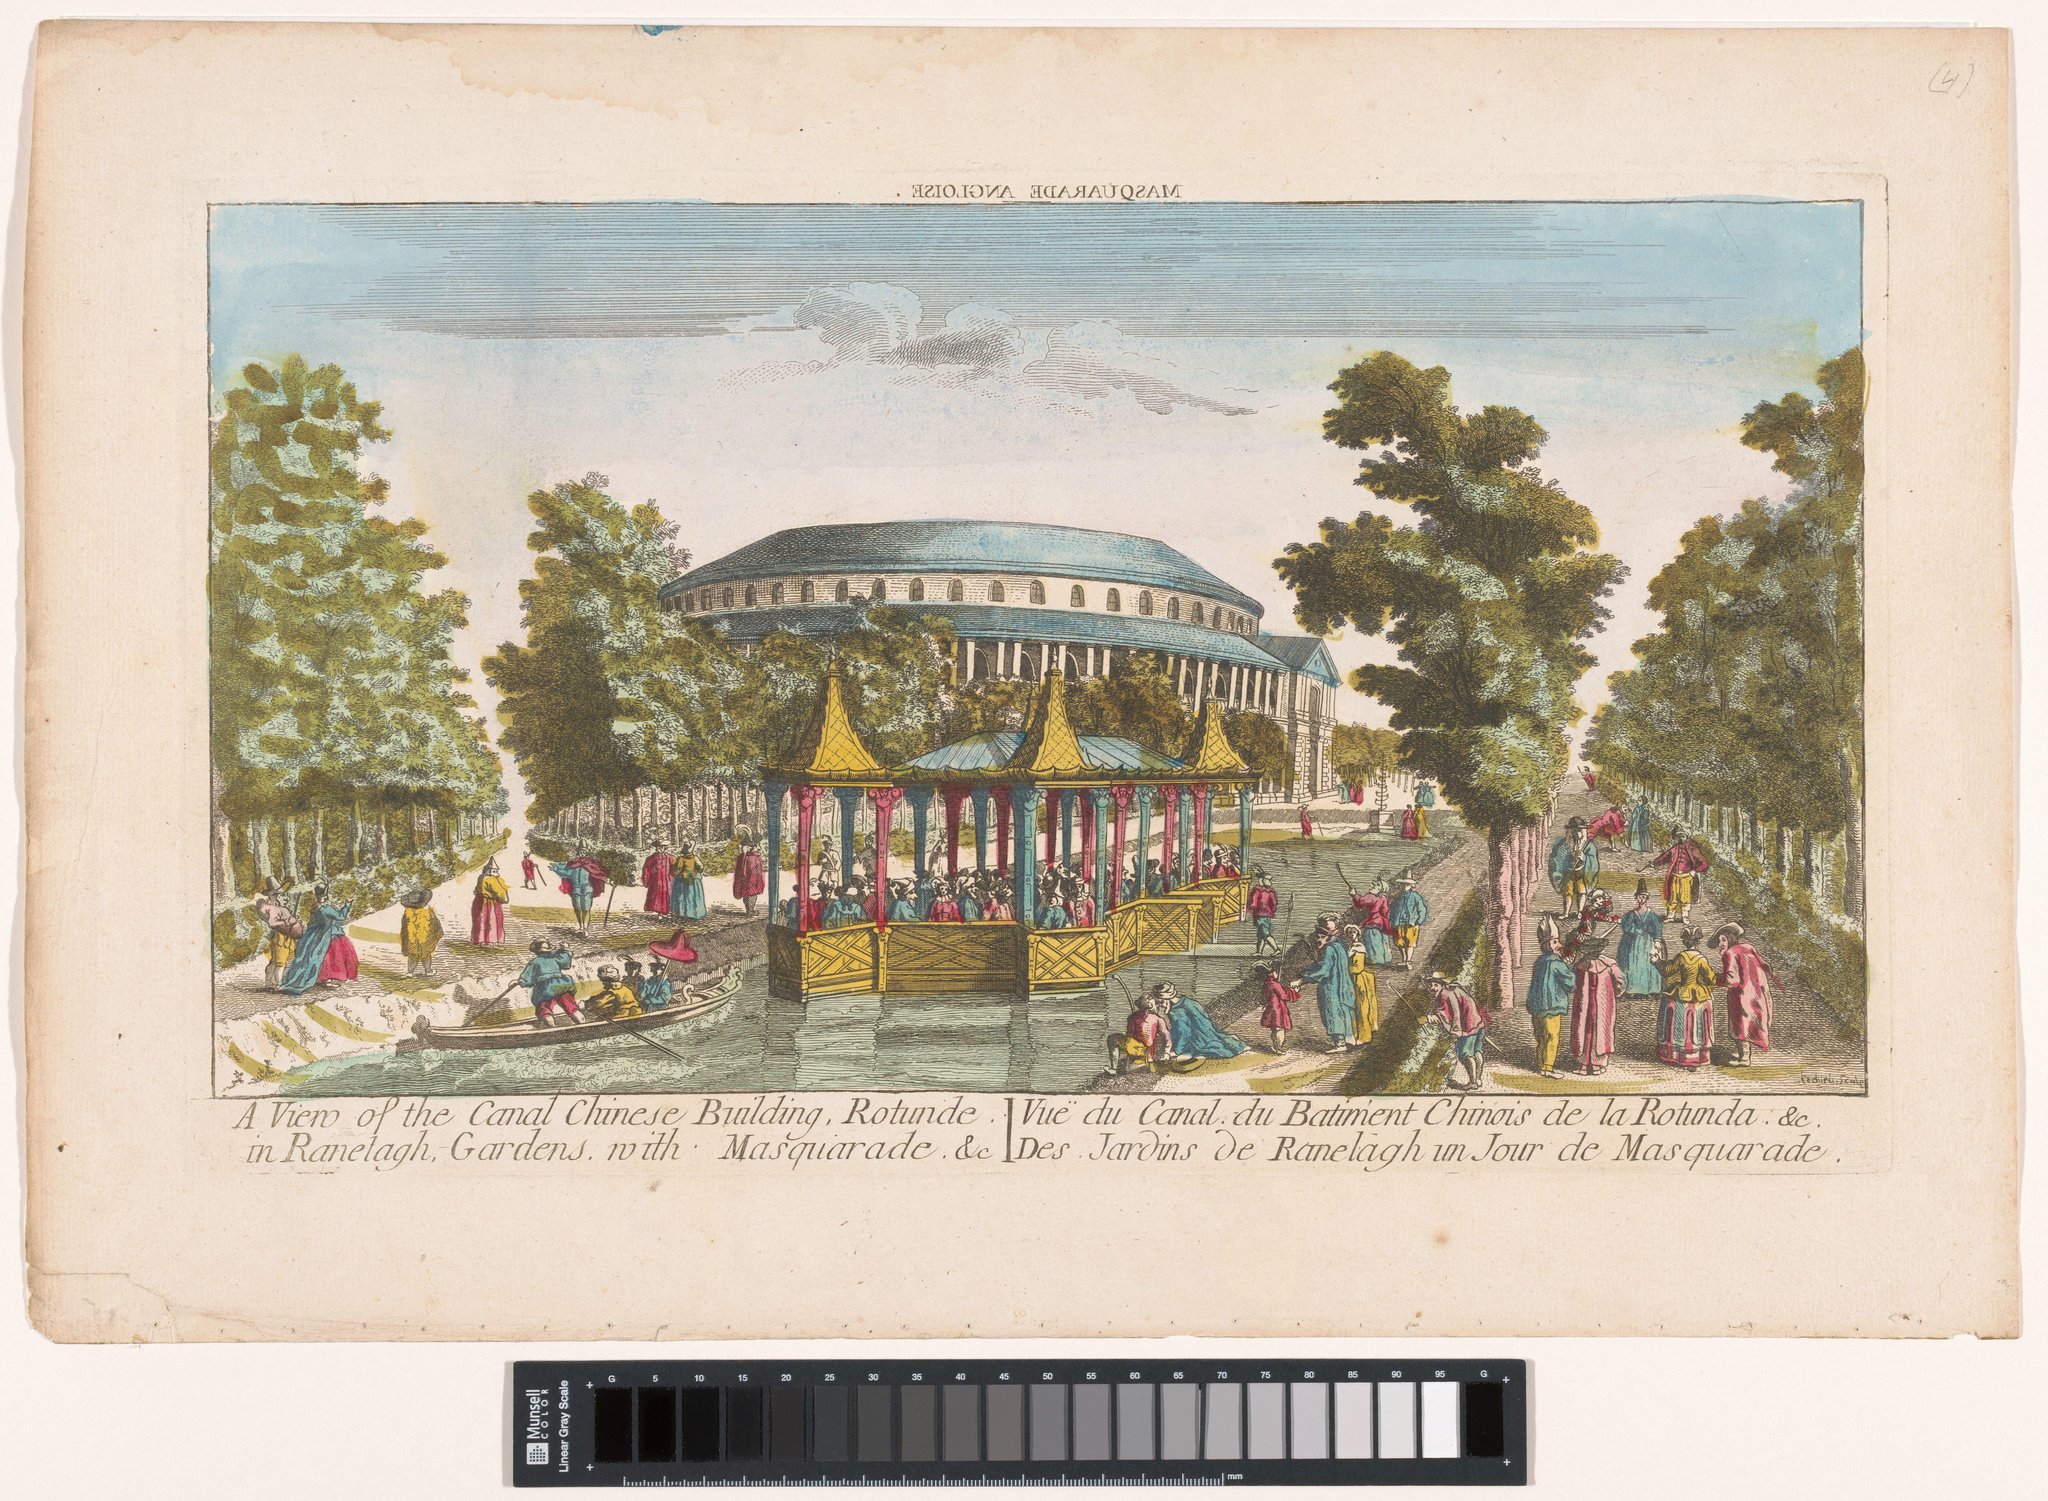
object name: print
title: Gezicht op de Rotunda en het Chinese paviljoen op het kanaal in Ranelagh Gardens te Londen met een gemaskerd bal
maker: Anonymous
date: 1752-1799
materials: paper, watercolor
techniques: brush, etching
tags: garden, canal, masquerade, masked ball, civic architecture; edifices; dwellings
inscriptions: collector's mark: Lugt 2166